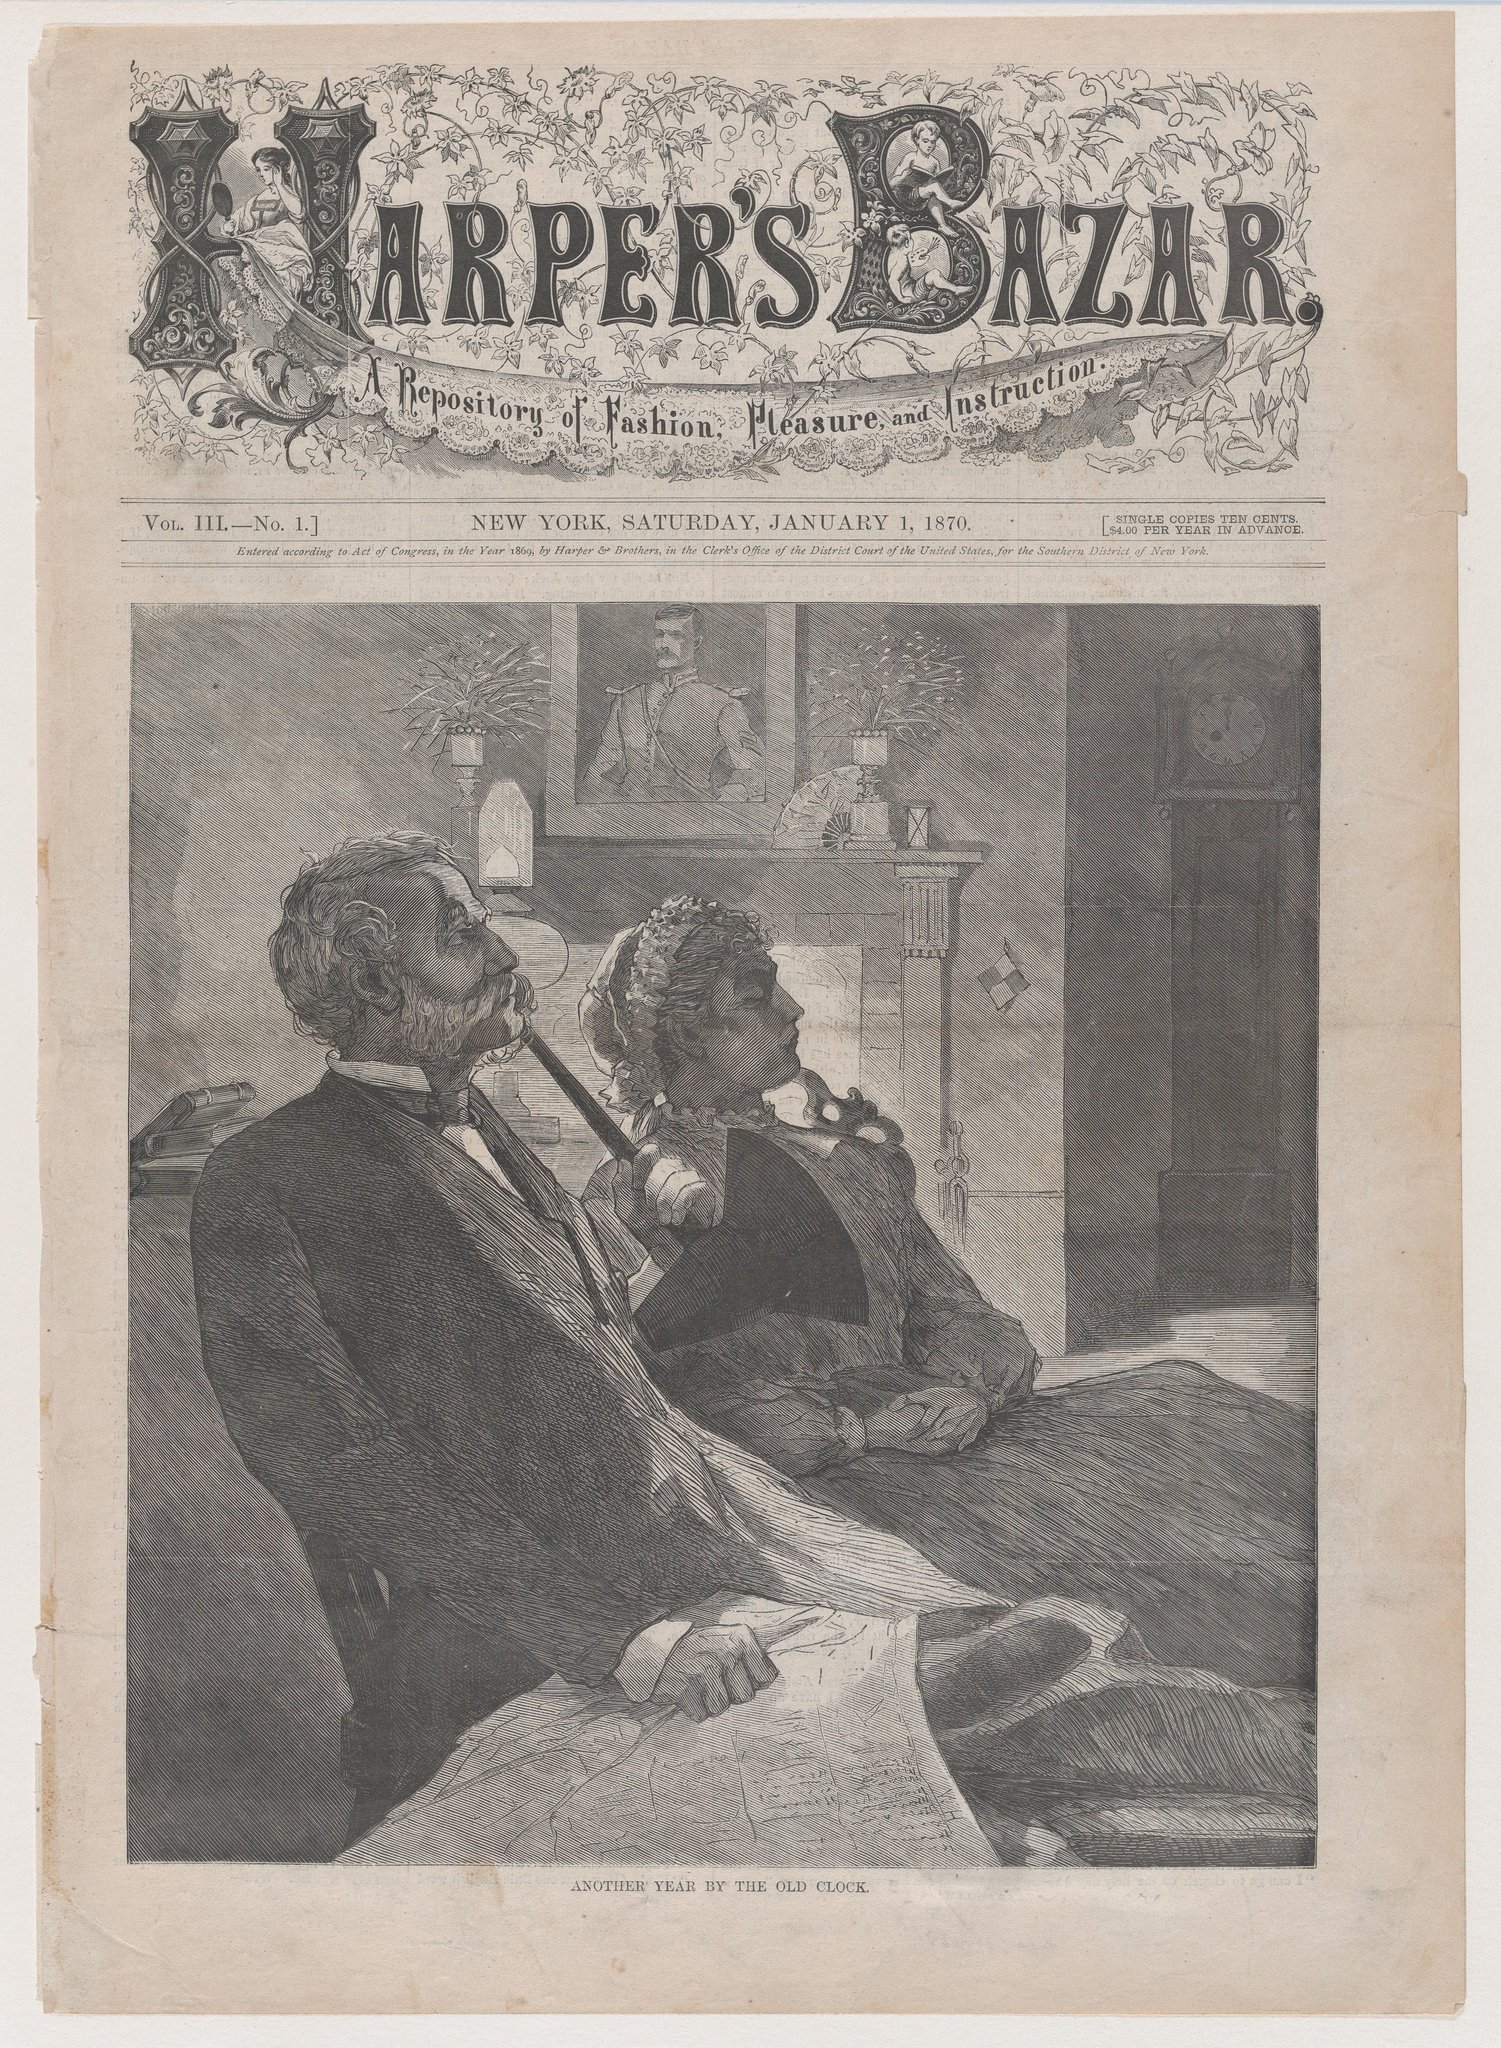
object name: print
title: Another Year by the Old Clock (from "Harper's Bazar," Vol. III)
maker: winslow homer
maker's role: artist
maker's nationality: american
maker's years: 1836-1910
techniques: engraving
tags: men,women